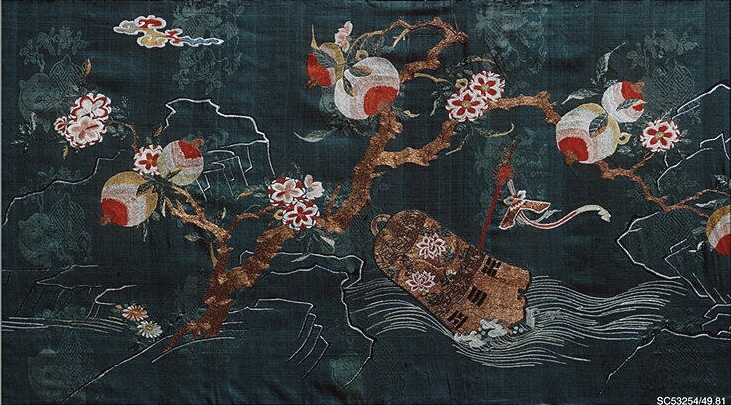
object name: valance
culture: chinese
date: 1701-1733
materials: metal thread, silk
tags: pomegranates,trees,bells